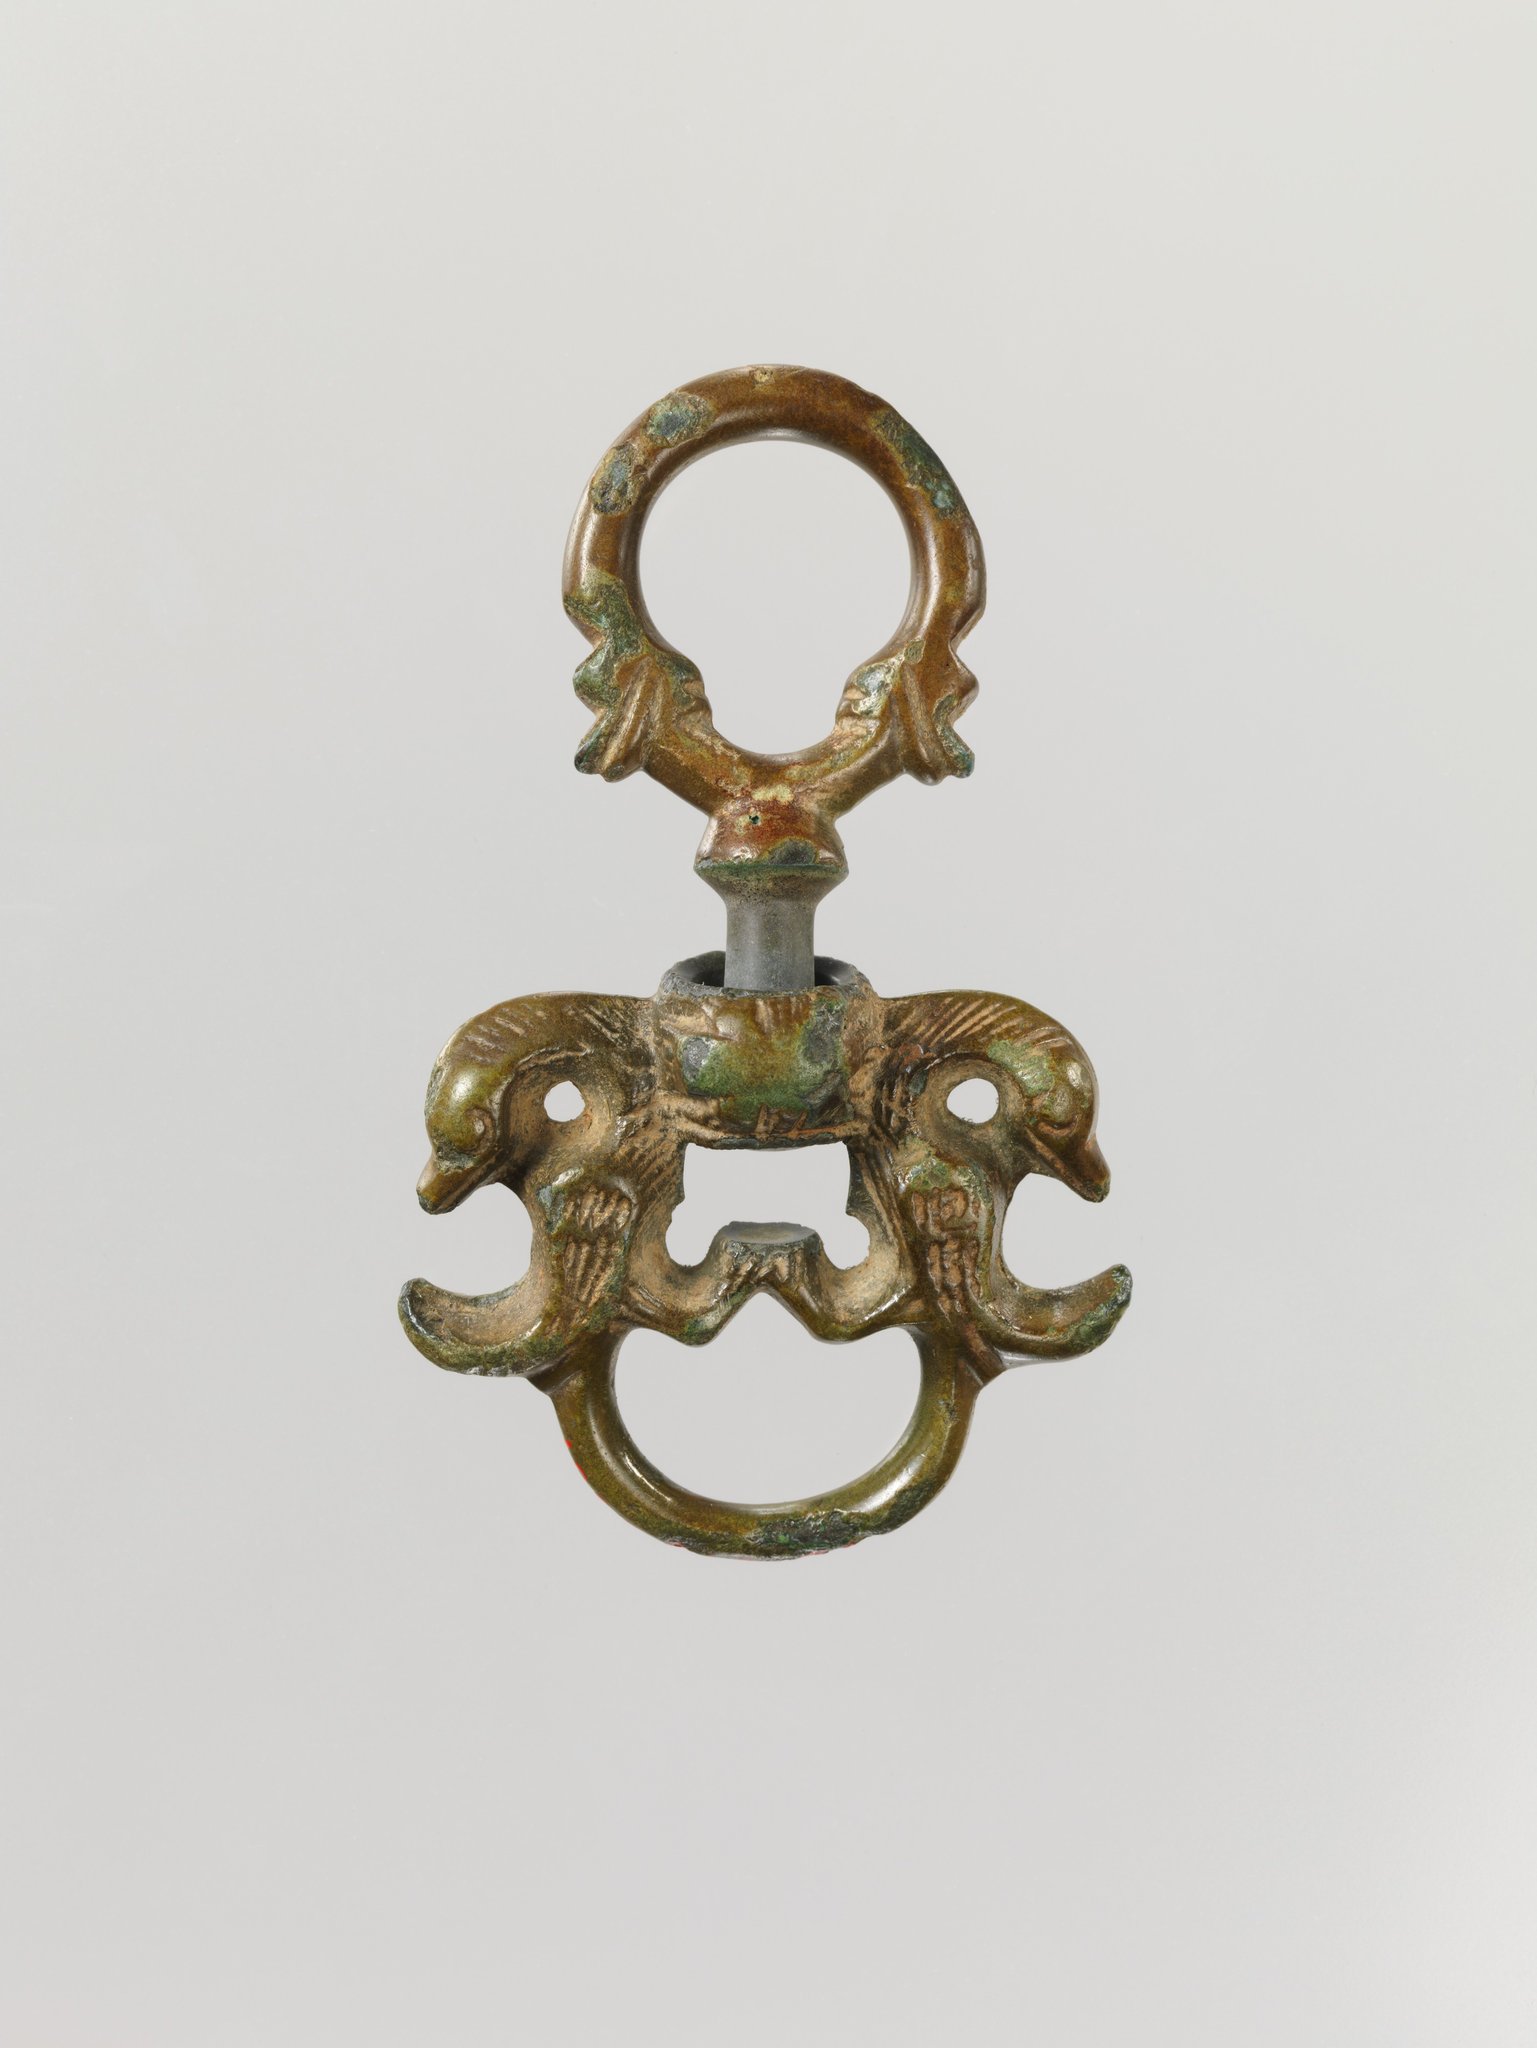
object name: fitting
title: Fitting with two birds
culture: chinese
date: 500-201 BCE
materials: bronze